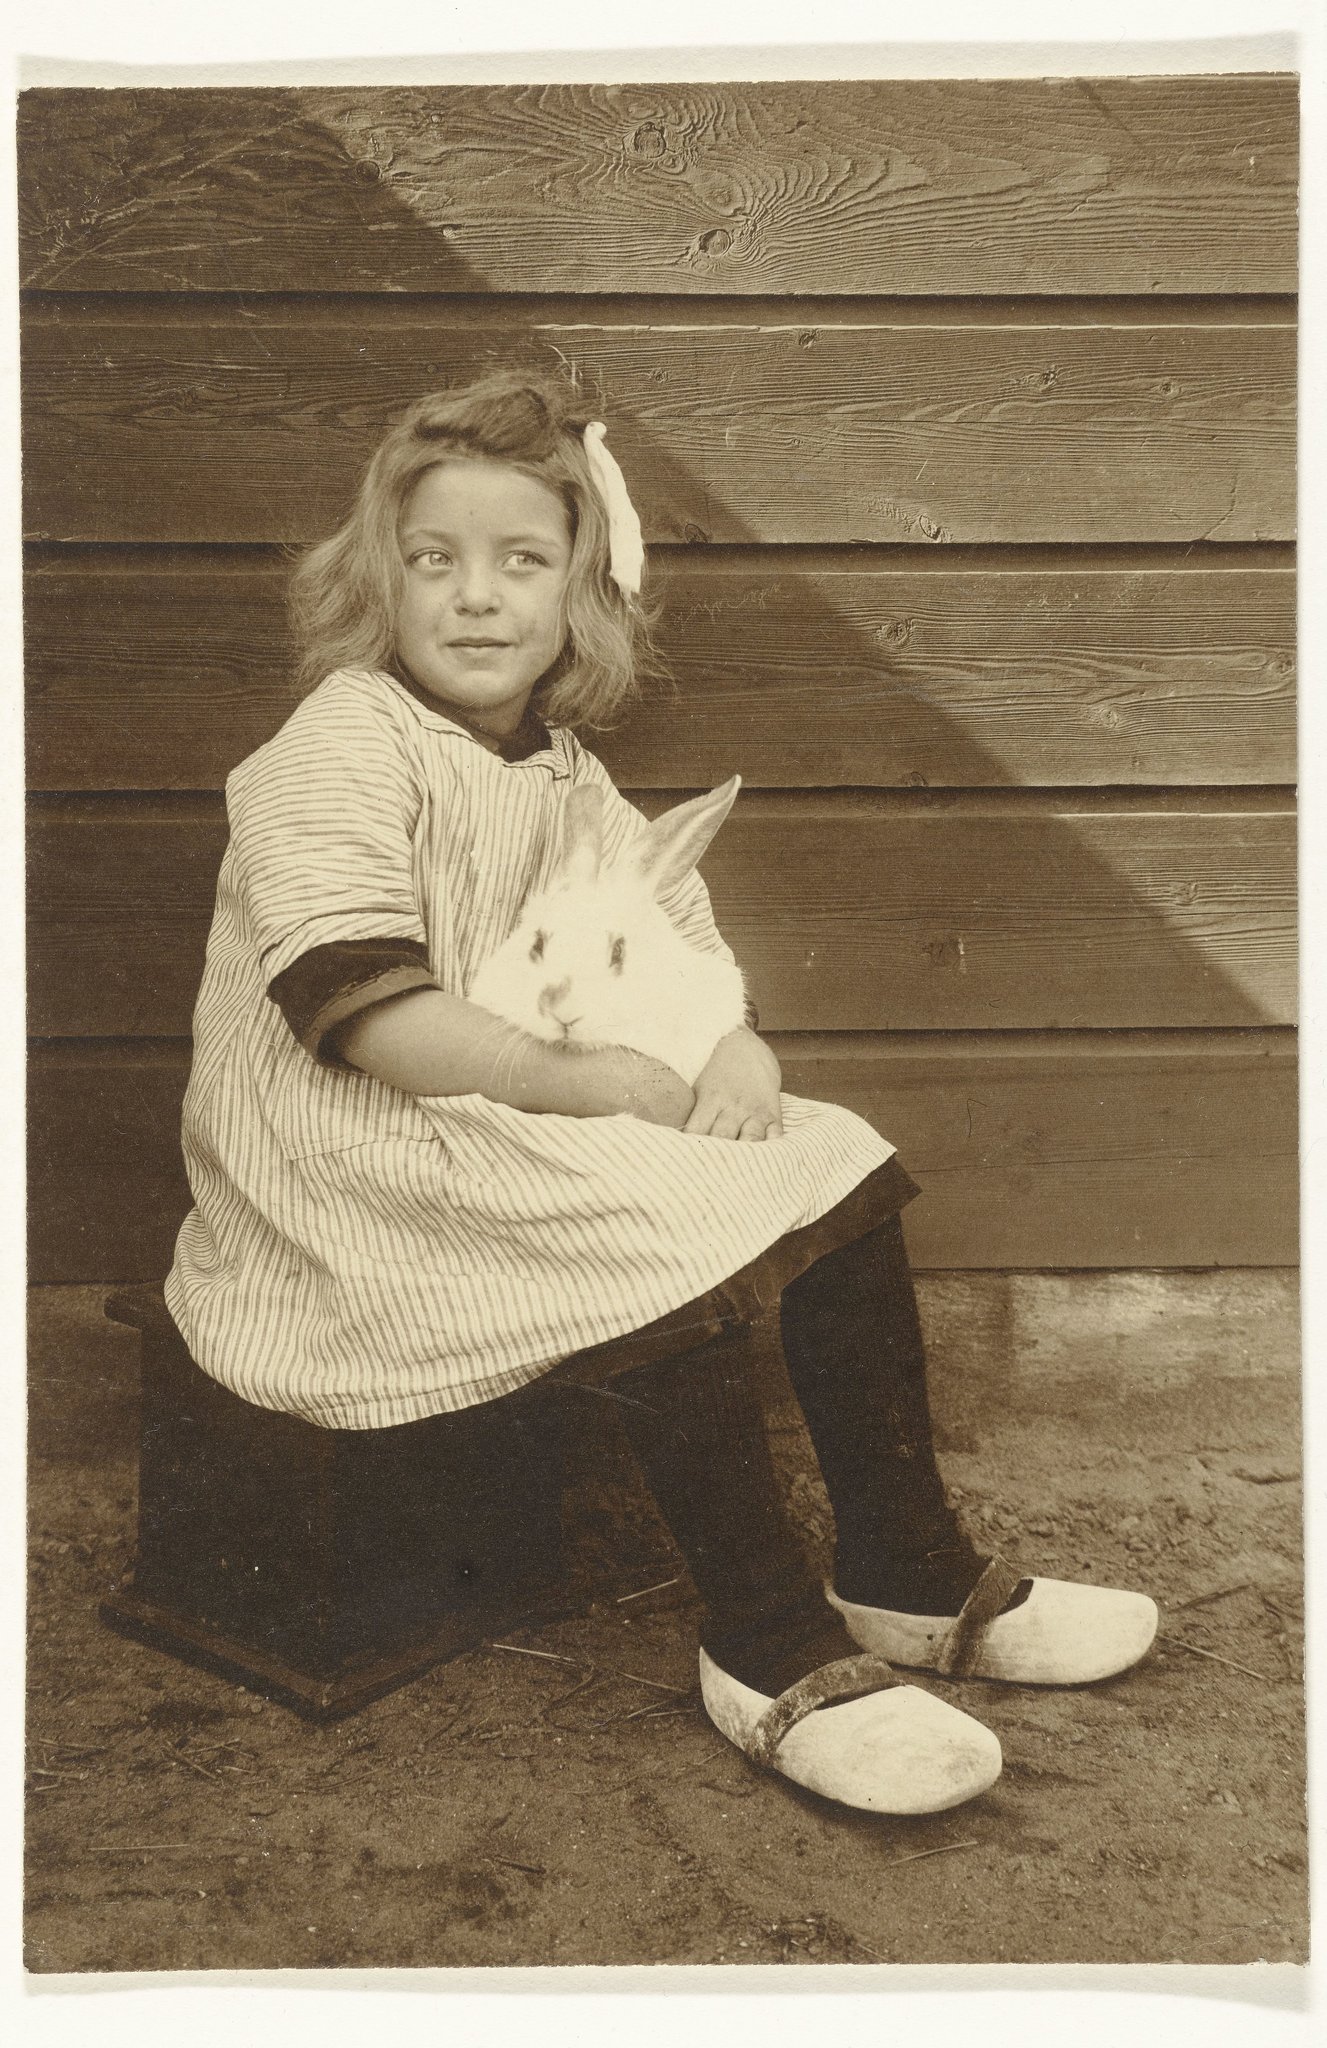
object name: photograph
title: Kind met konijn op schoot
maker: richard tepe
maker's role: fotograaf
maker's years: 1864-1952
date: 1900-1930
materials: paper, photographic support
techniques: gelatin silver print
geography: netherlands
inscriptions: annotation: ‘Kind met konijn’, signature: ‘foto R Tepe’